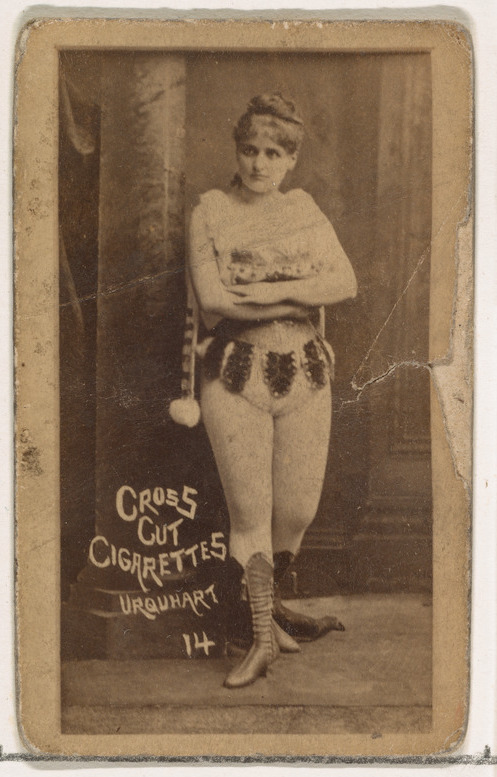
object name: print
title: Card Number 14, Urquhart, from the Actors and Actresses series (N145-1) issued by Duke Sons & Co. to promote Cross Cut Cigarettes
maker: w. duke, sons & co.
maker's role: publisher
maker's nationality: american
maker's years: 1870-1920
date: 1880-1889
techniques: albumen silver print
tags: portraits,women,actresses